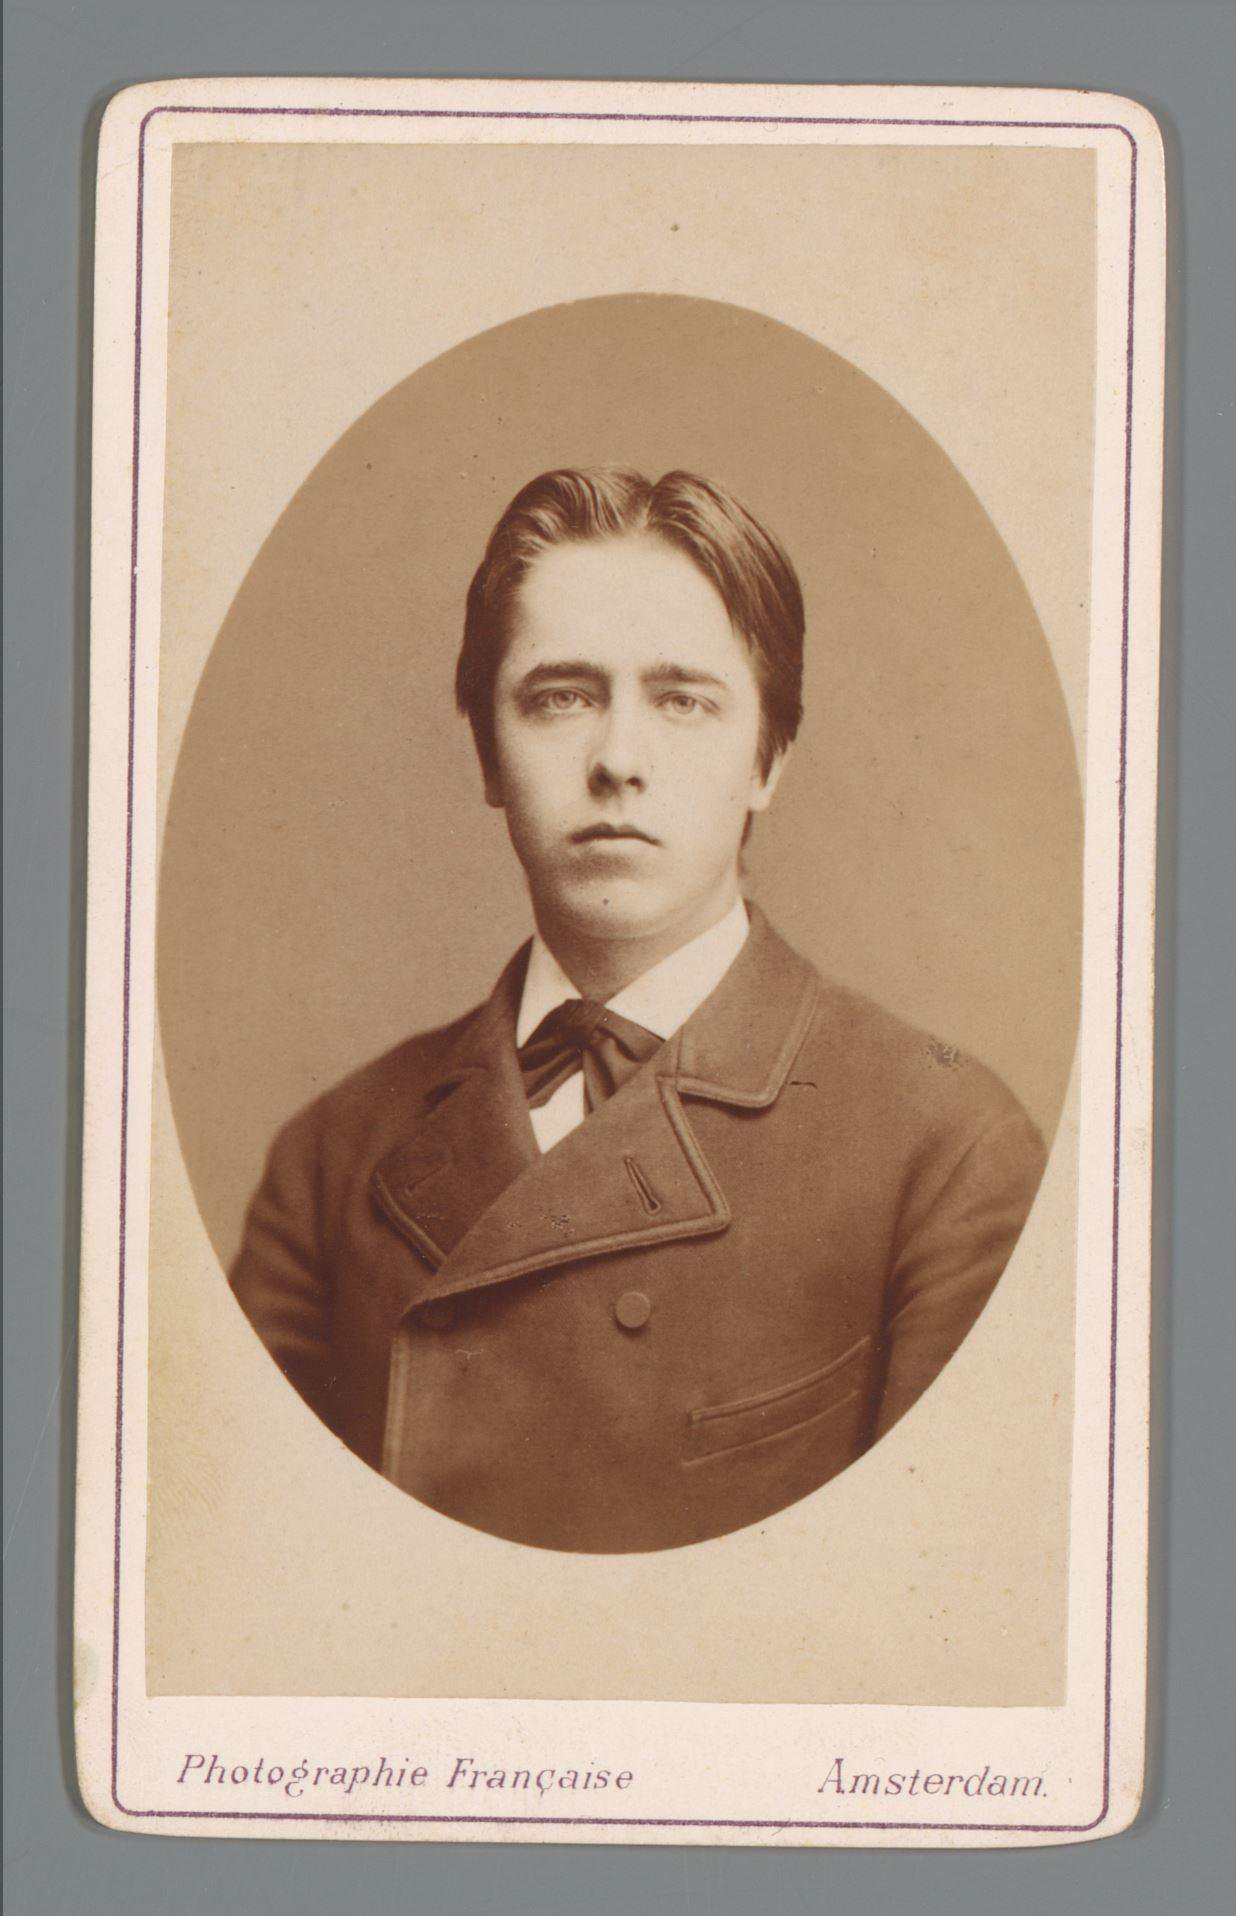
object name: carte de visite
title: Portret van Willem Jonker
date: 1870-1900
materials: cardboard, photographic support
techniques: albumen print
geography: amsterdam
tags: historical persons, amsterdam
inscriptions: workshop stamp: ‘Photographie Française/ Warmoesstraat 147, Amsterdam’, annotation: ‘W. Jonker’